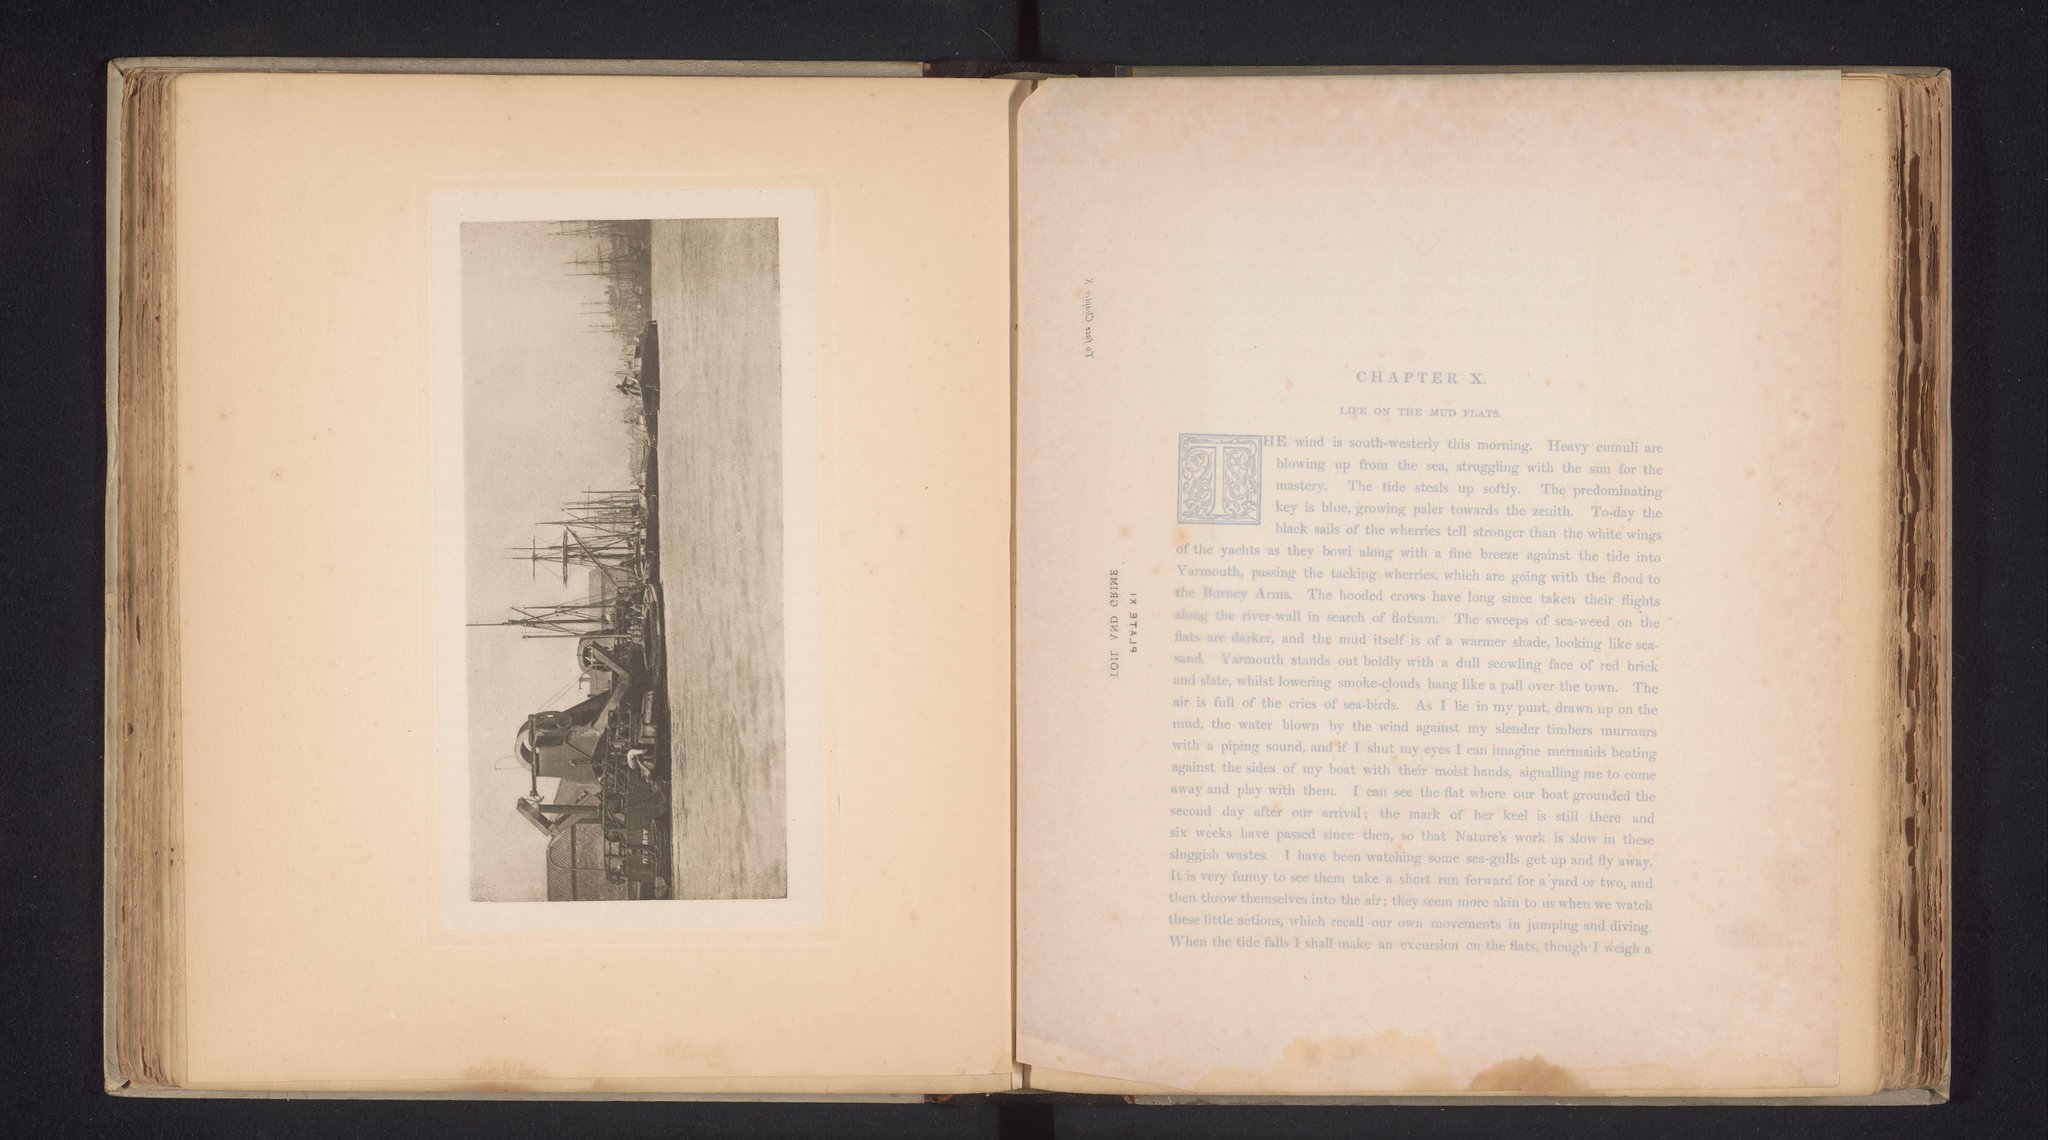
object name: photomechanical print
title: Aangemeerde schepen (vermoedelijk) te Great Yarmouth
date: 1880-1890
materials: paper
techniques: photoaquatint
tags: harbour, river, ships (in general) - cc - more than one ship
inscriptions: inscription: ‘Toil and grime’, number: ‘Plate XI’